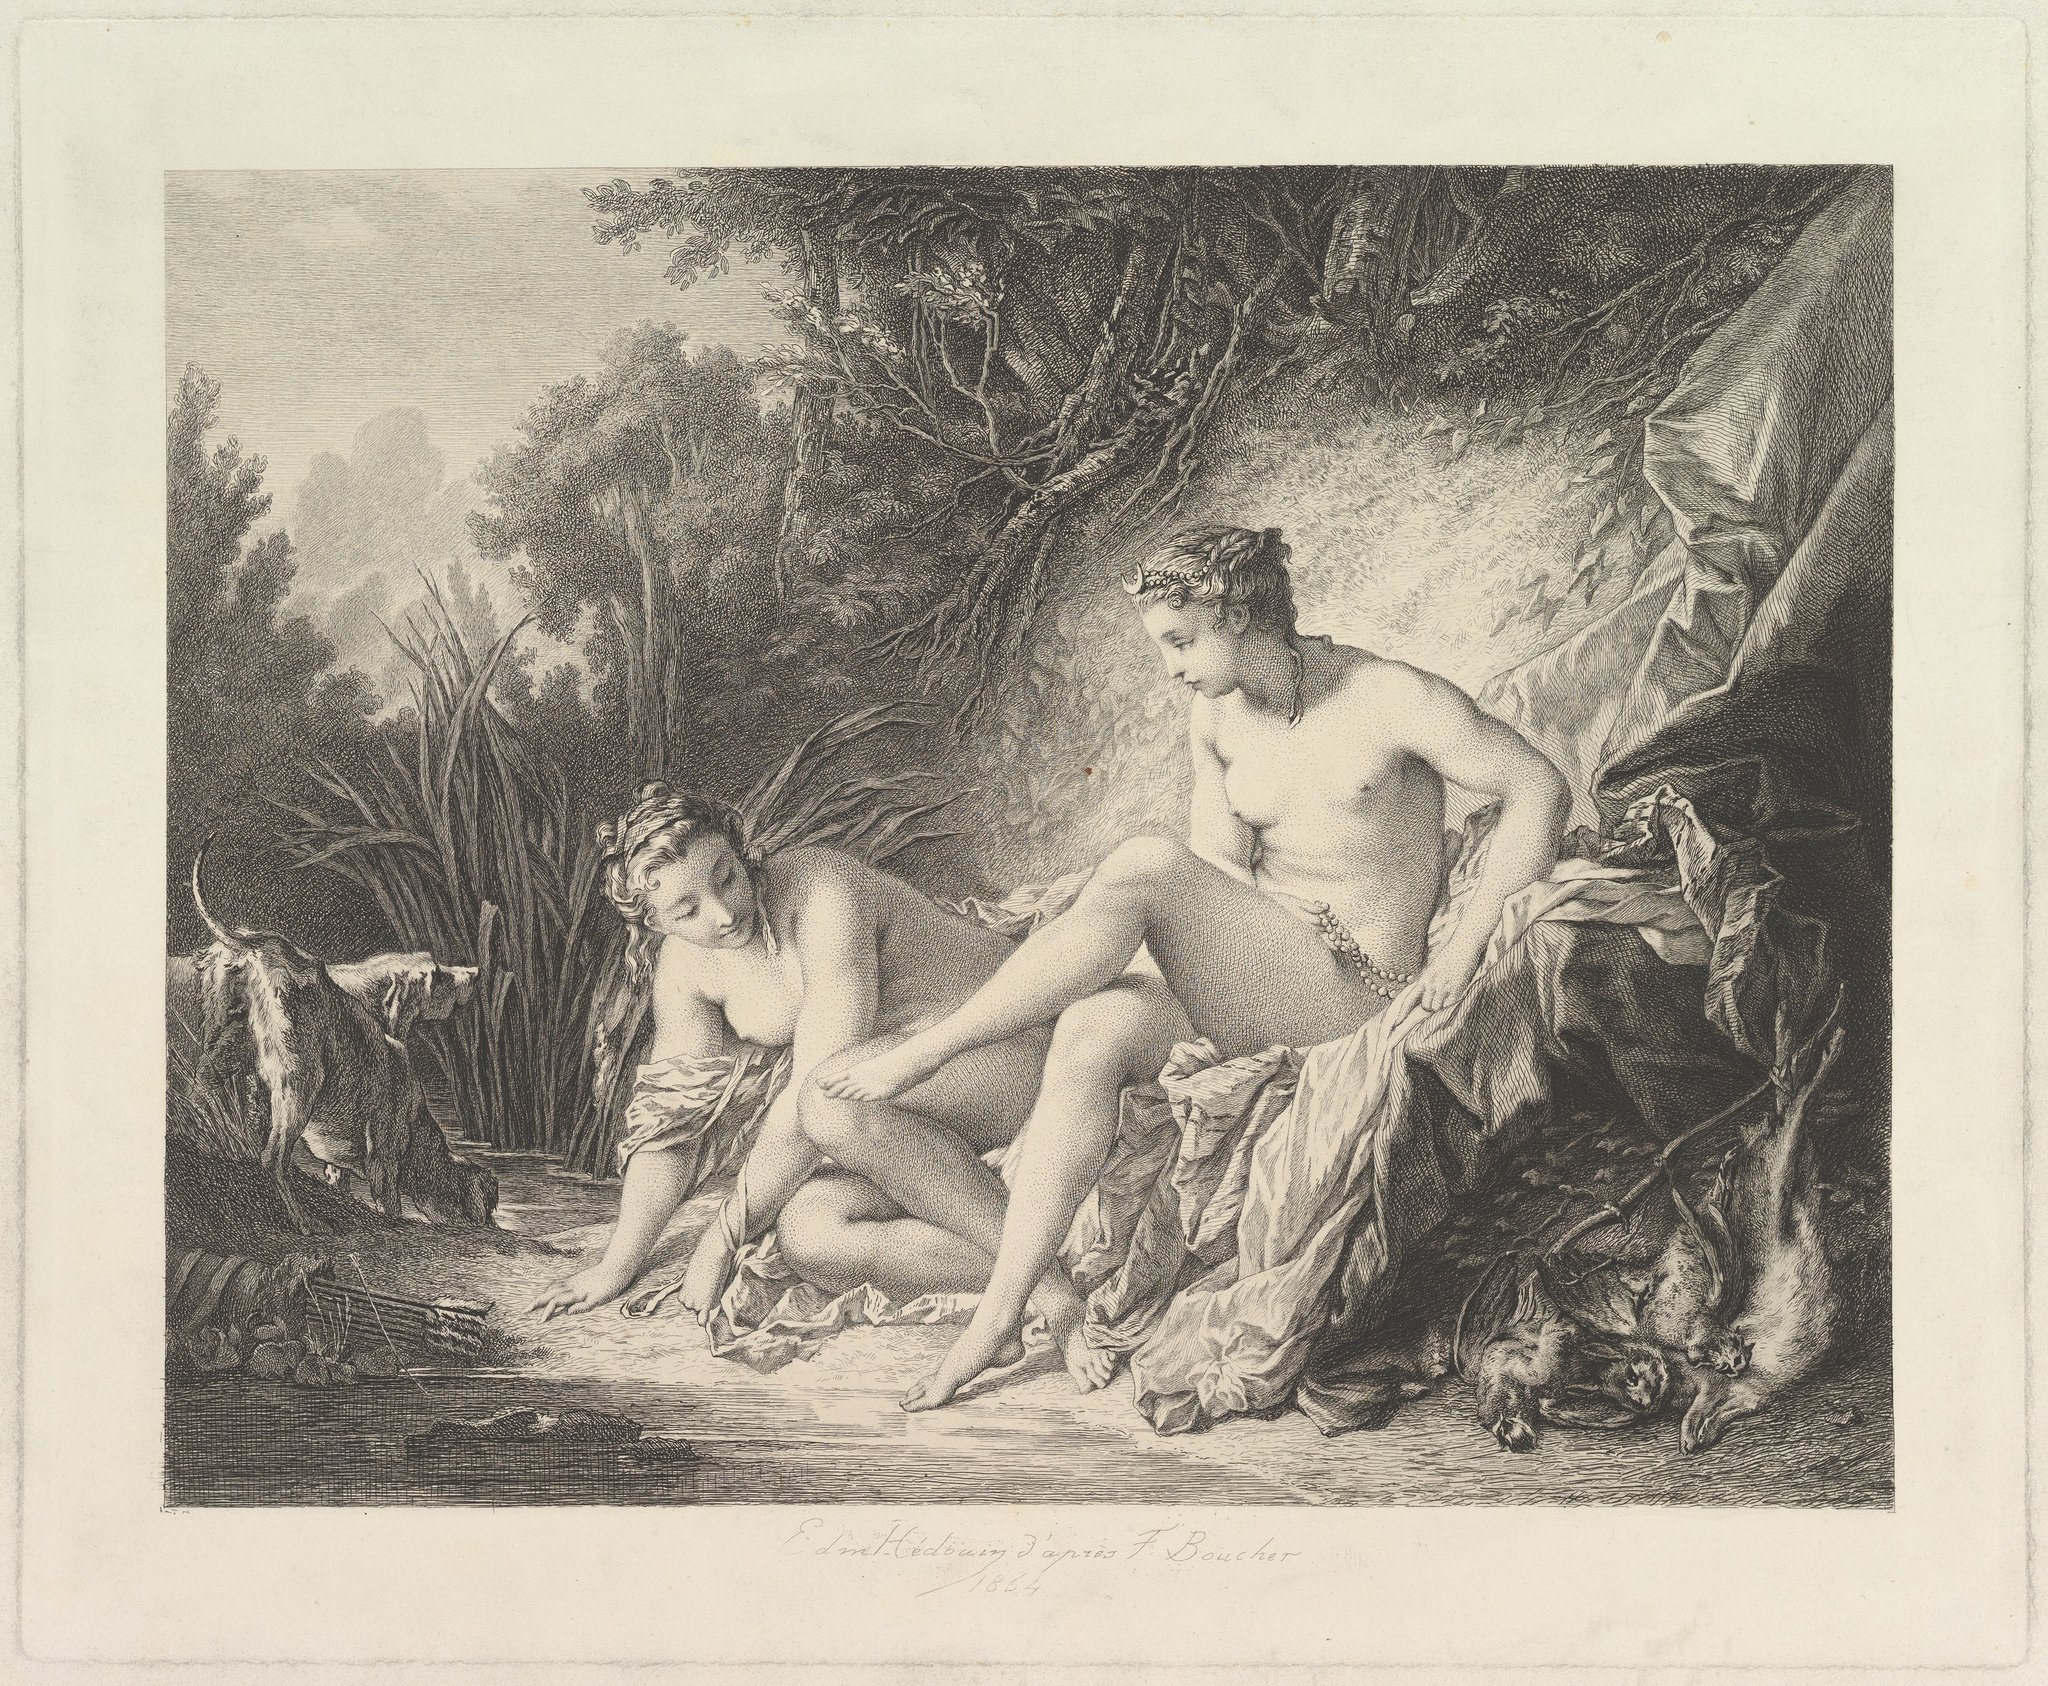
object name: print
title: Diana Sourtant du Bain (Diana Leaving the Bath)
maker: edmond hédouin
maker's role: artist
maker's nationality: french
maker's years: 1820-1889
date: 1864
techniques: engraving, etching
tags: female nudes,diana